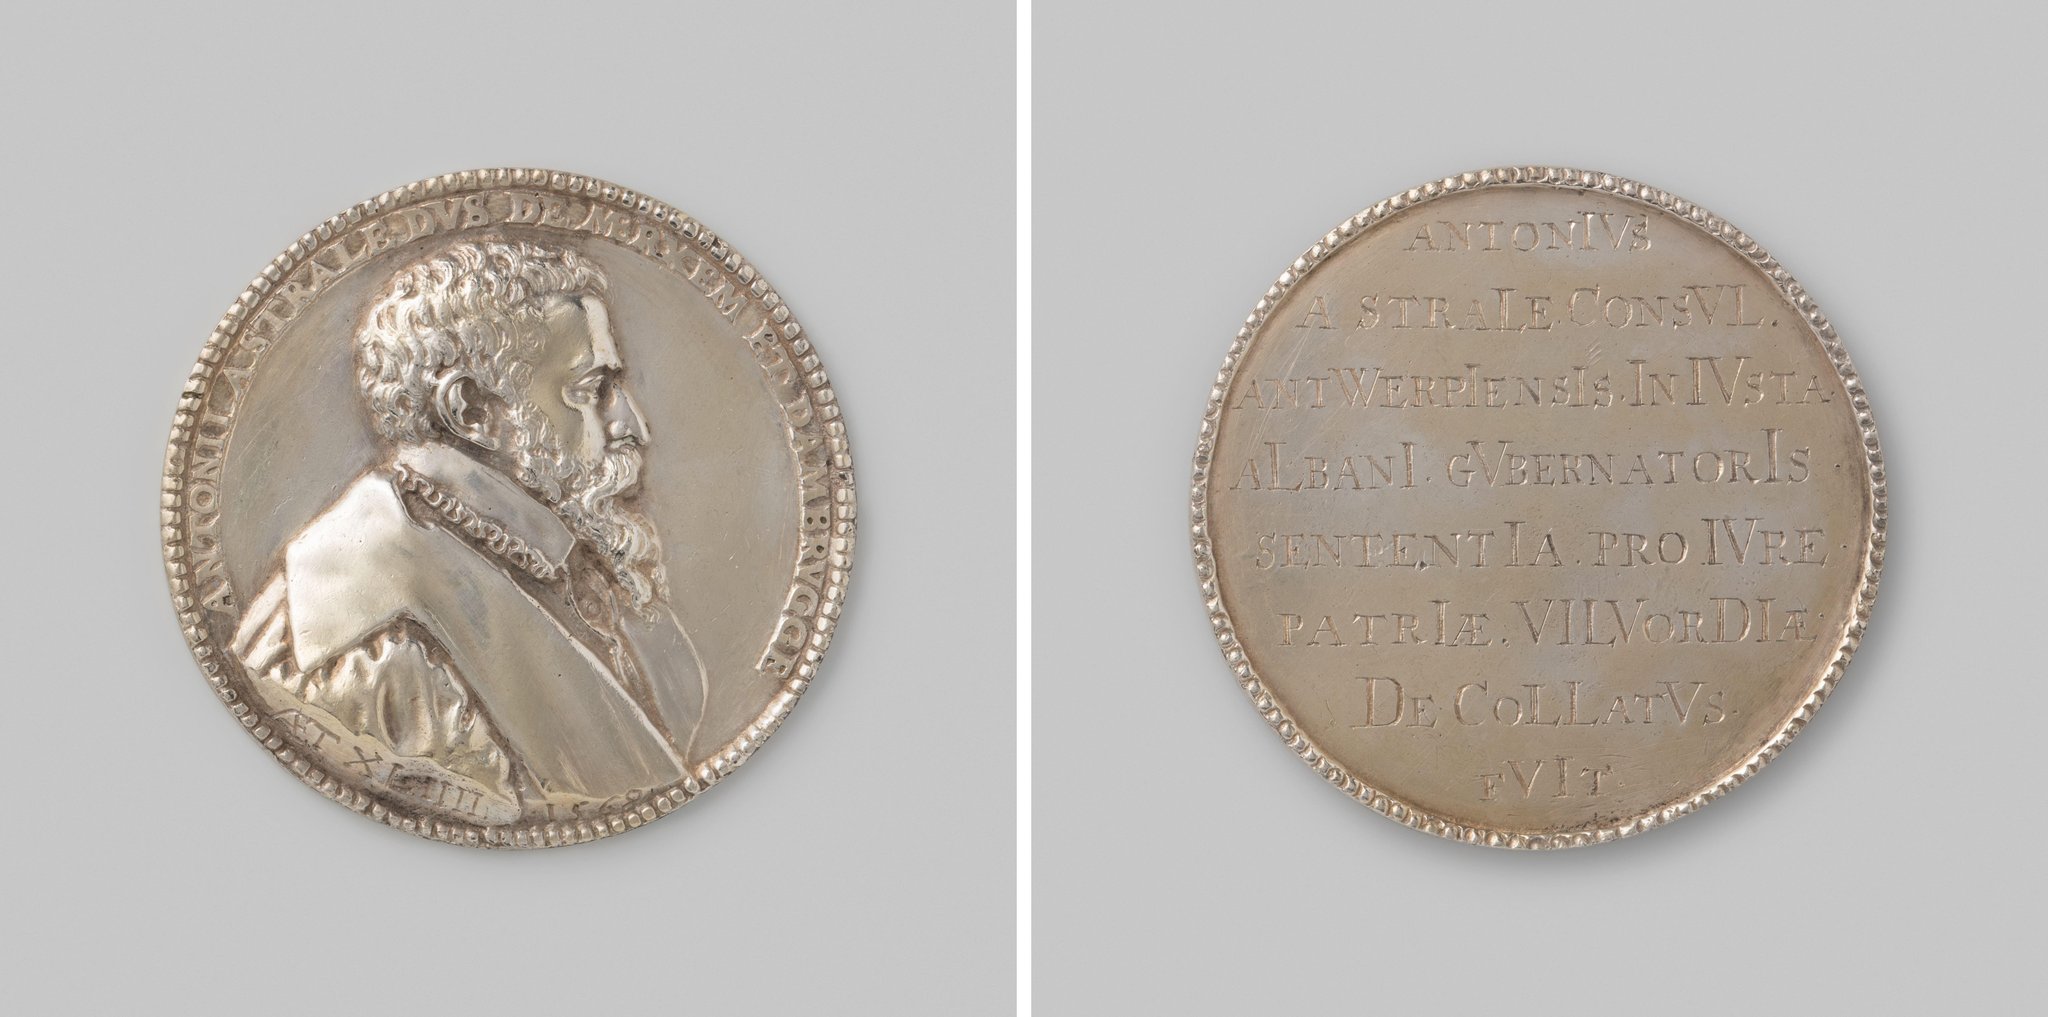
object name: copy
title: Onthoofding van Anthony van Stralen, heer van Merssem en Dambrugge, burgemeester van Antwerpen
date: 1566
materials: silver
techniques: casting, engraving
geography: antwerp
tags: antwerp, mayor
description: Emergency coins, silver. These makeshift coins were used during the siege of Groningen by troops of the bishops of Cologne and Münster in 1672.